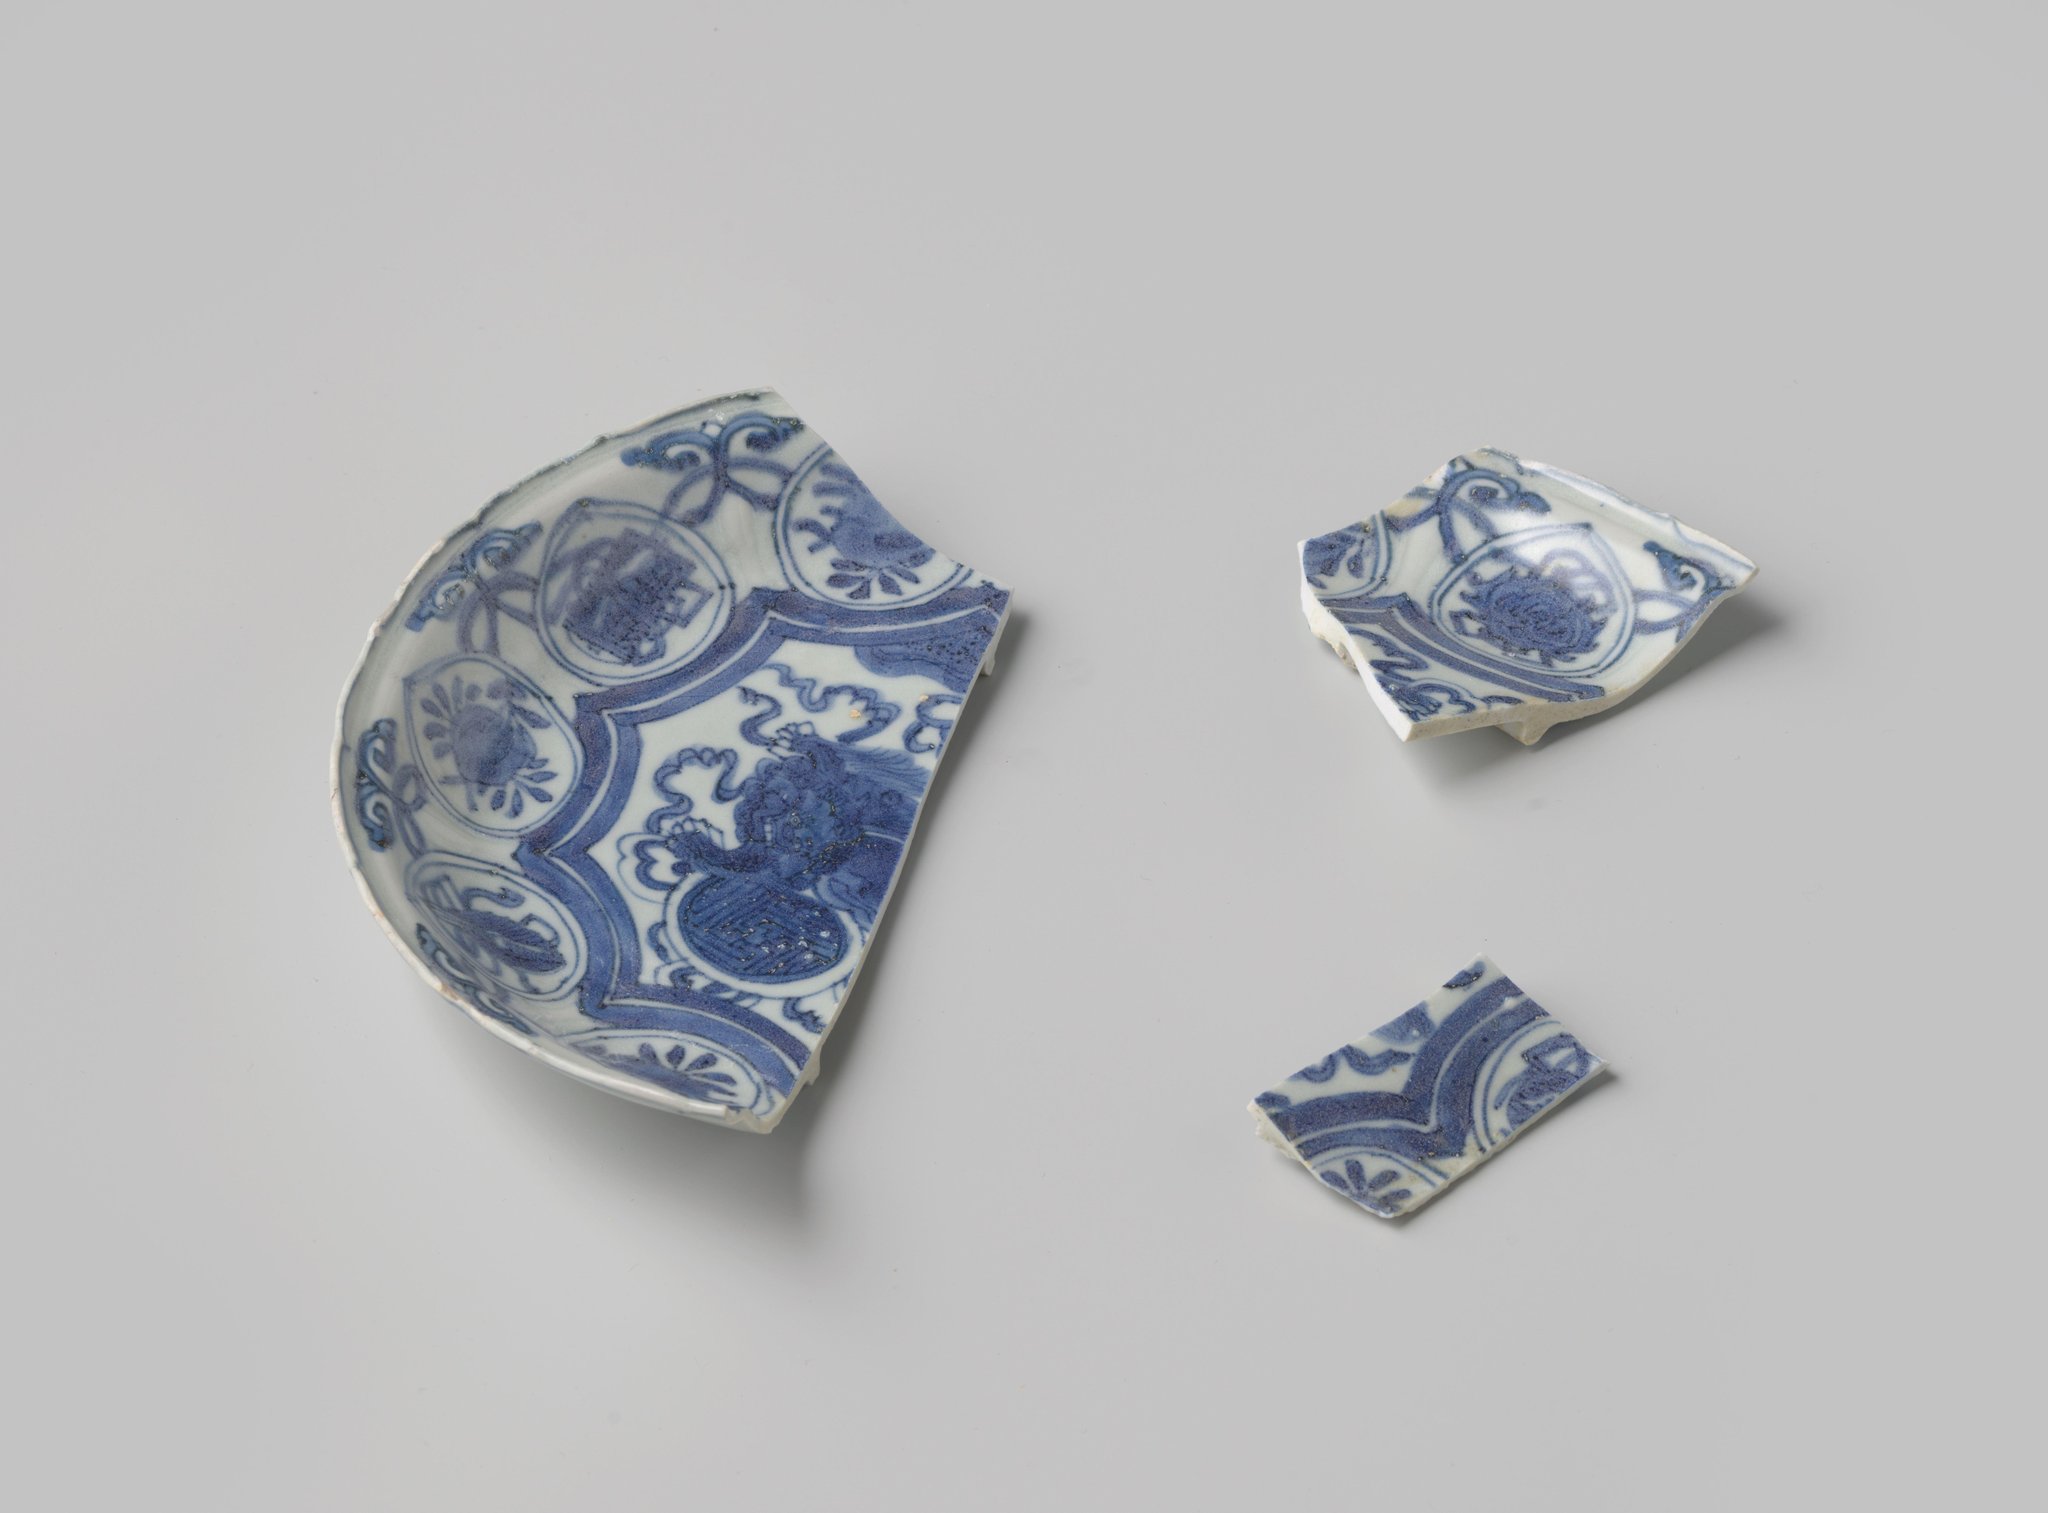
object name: sherd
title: Scherven van een bord uit V.O.C.-schip de 'Witte leeuw'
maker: Anonymous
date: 1613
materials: bone china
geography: jingdezhen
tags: verenigde oostindische compagnie, sint-helena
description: A dish without a flattened rim. A ten-sided medallion consisting of 2 thick bands. A central decoration of a Buddhist lion with possibly a brocade ball. The medallion decorated alternately with peaches and symbols.